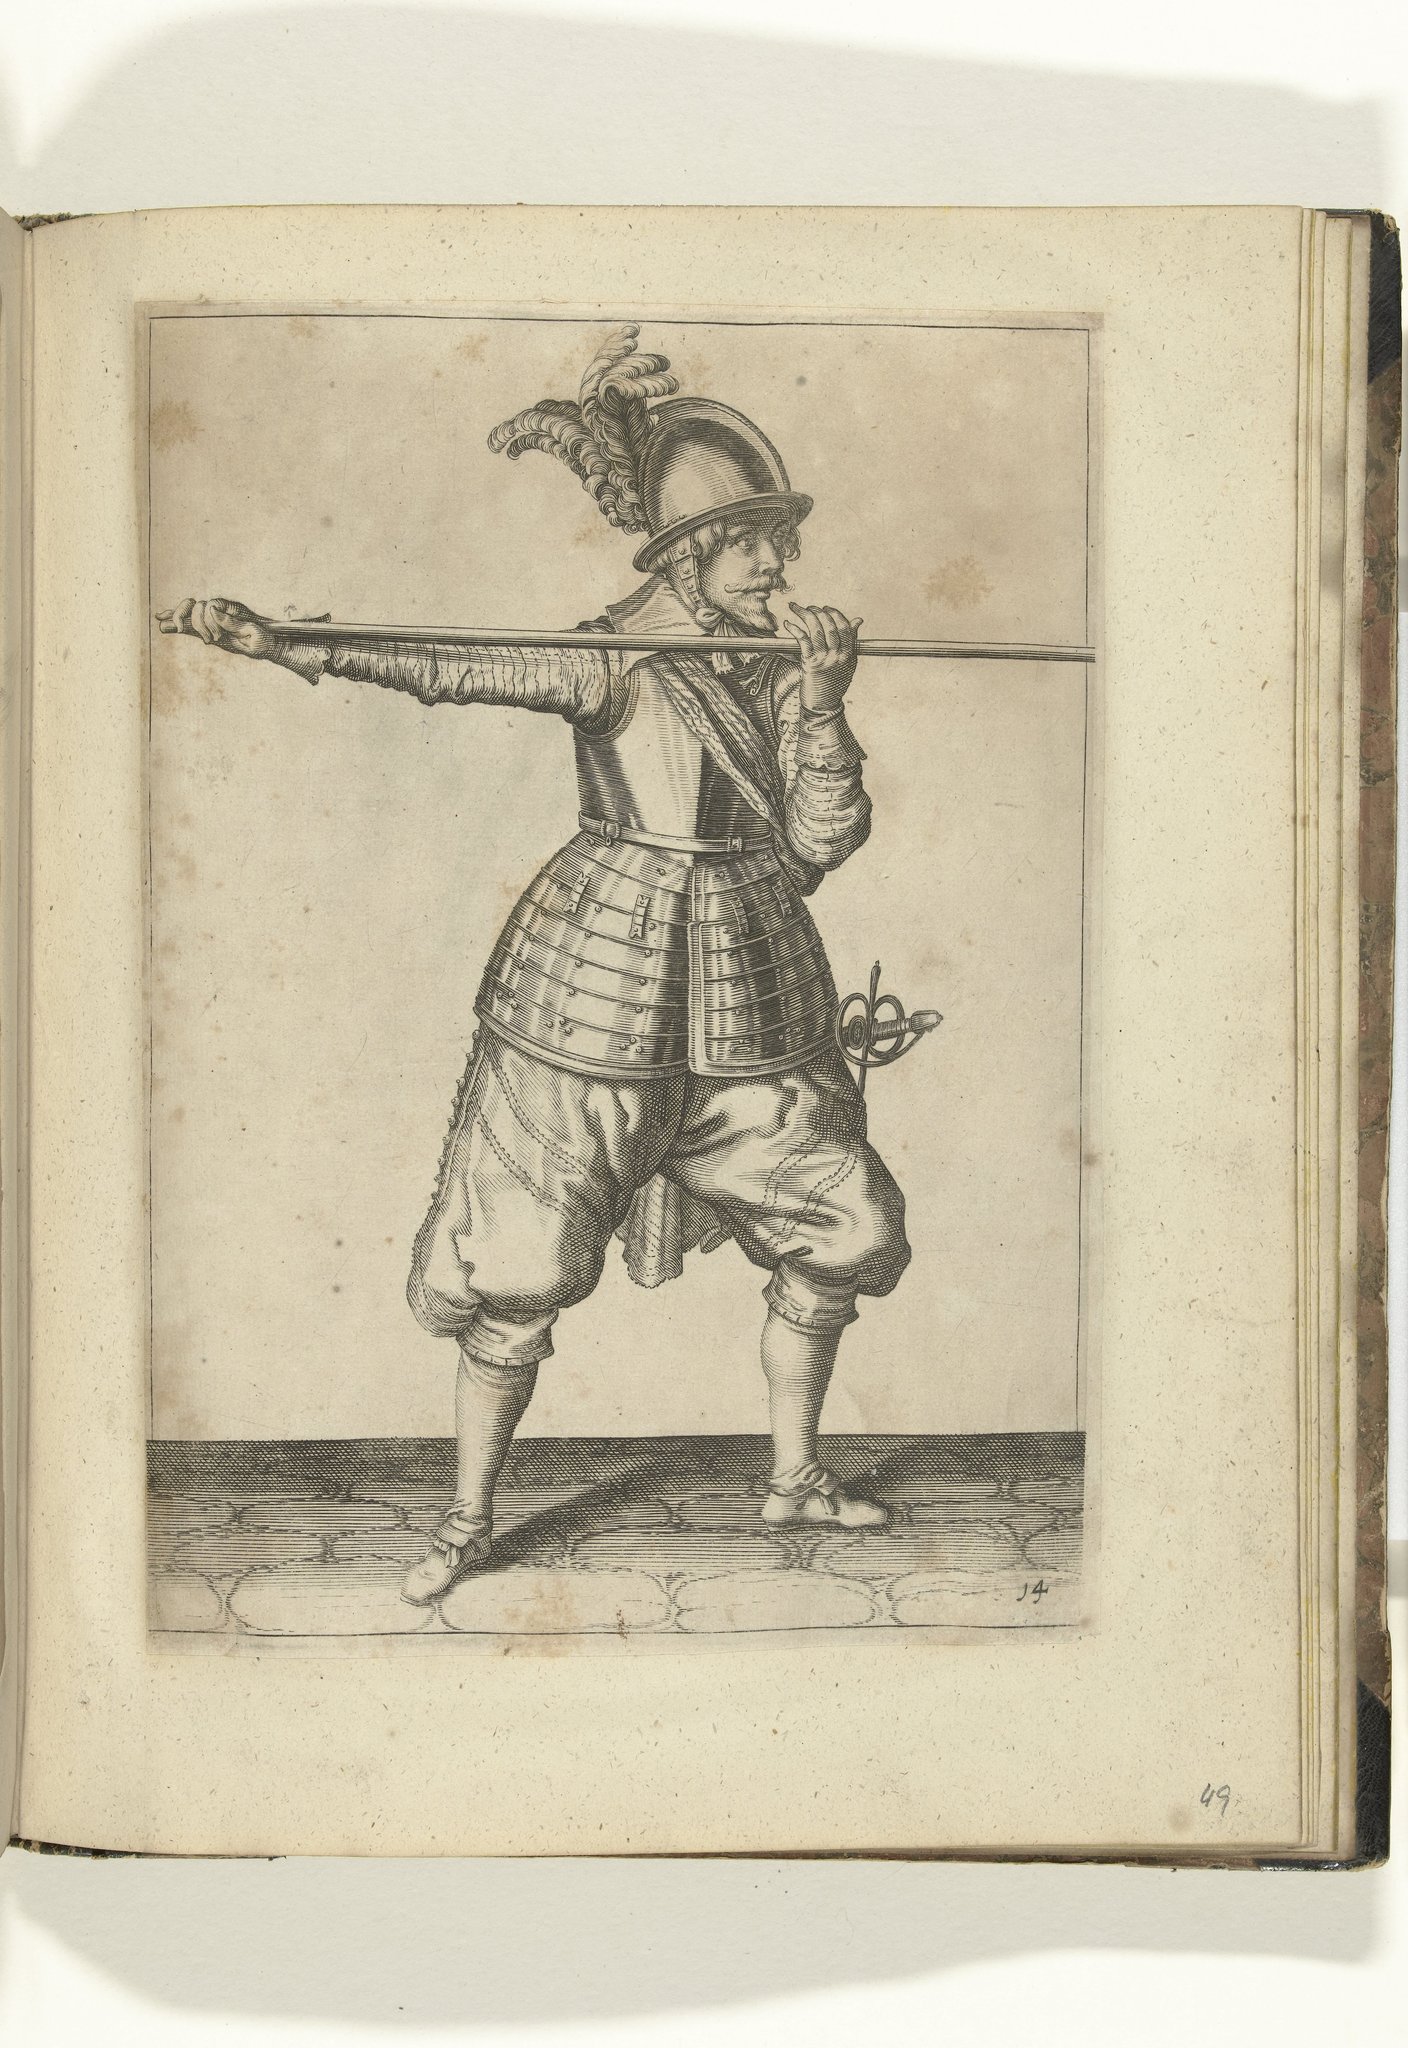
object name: print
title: Soldaat die zijn spies met beide handen horizontaal op schouderhoogte draagt, zijn rechterhand bij de voet van het wapen (nr. 14), ca. 1600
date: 1597-1608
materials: paper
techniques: engraving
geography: northern netherlands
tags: the hague, maurice (prince of orange), handling of weapons ~ military training, weapons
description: Een soldaat, ten voeten uit, die een spies (lans) met beide handen horizontaal op schouderhoogte draagt, zijn rechterhand bij de voet van het wapen (nr. 14), ca. 1600. Dit is de derde handeling voor het laten zakken van de spies om onder een overwelving door te kunnen. Plaat 14 in de instructies voor het hanteren van de spies: Brief instruction upon the contrefaictinges, concerning the right use, of all what a Souldier needeth to know in handling of the Pike. Onderdeel van de illustraties in een Engelse editie van J. de Gheyns Wapenhandelinghe: J. de Gheyn, The exercise of armes for calivres, muskettes and pikes after the ordre of Maurits Prince of Orange, 's-Gravenhage 1608. Krijgswezen rond 1600.